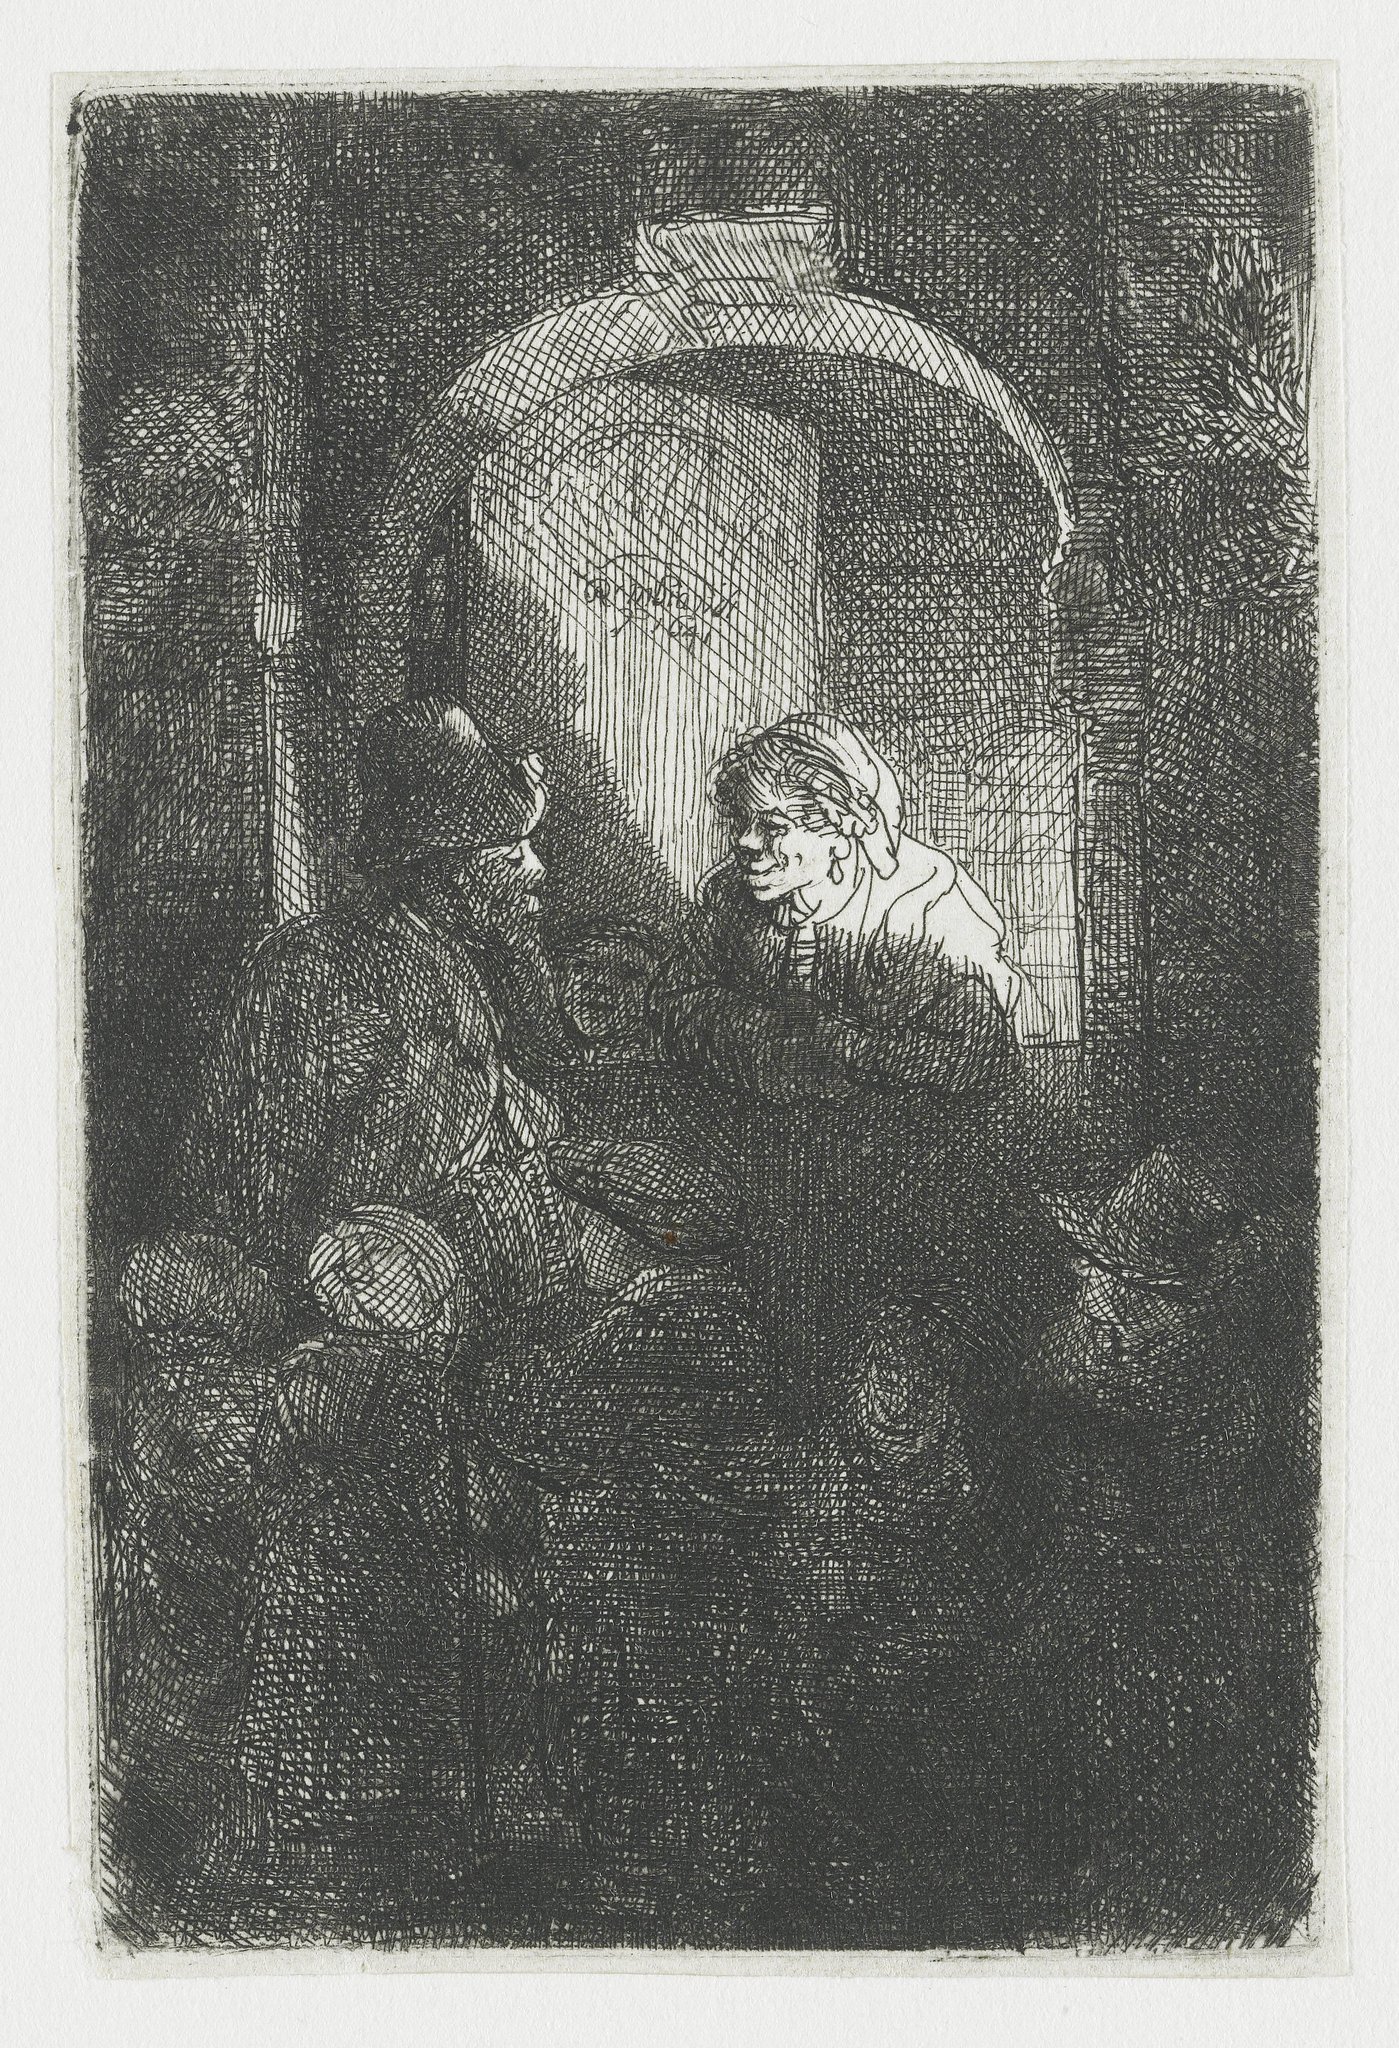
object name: print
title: A Hurdy-gurdy Player Followed by Children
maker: rembrandt van rijn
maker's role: draughtsman, painter, print maker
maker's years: 1606-1669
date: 1641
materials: paper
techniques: etching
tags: child teaching teacher, parents, or other adults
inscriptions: collector's mark: Lugt 240, signature and date: ‘Rembrandt f 1641’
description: Music echoes in all of these street scenes. Three prints show a hurdy-gurdy player accompanied by his family or followed by a crush of children going door to door to play a tune and ask for alms. Often these musicians were blind and hence had a guide dog, as seen in the print at the upper left. There the child in the doorway beams with delight.